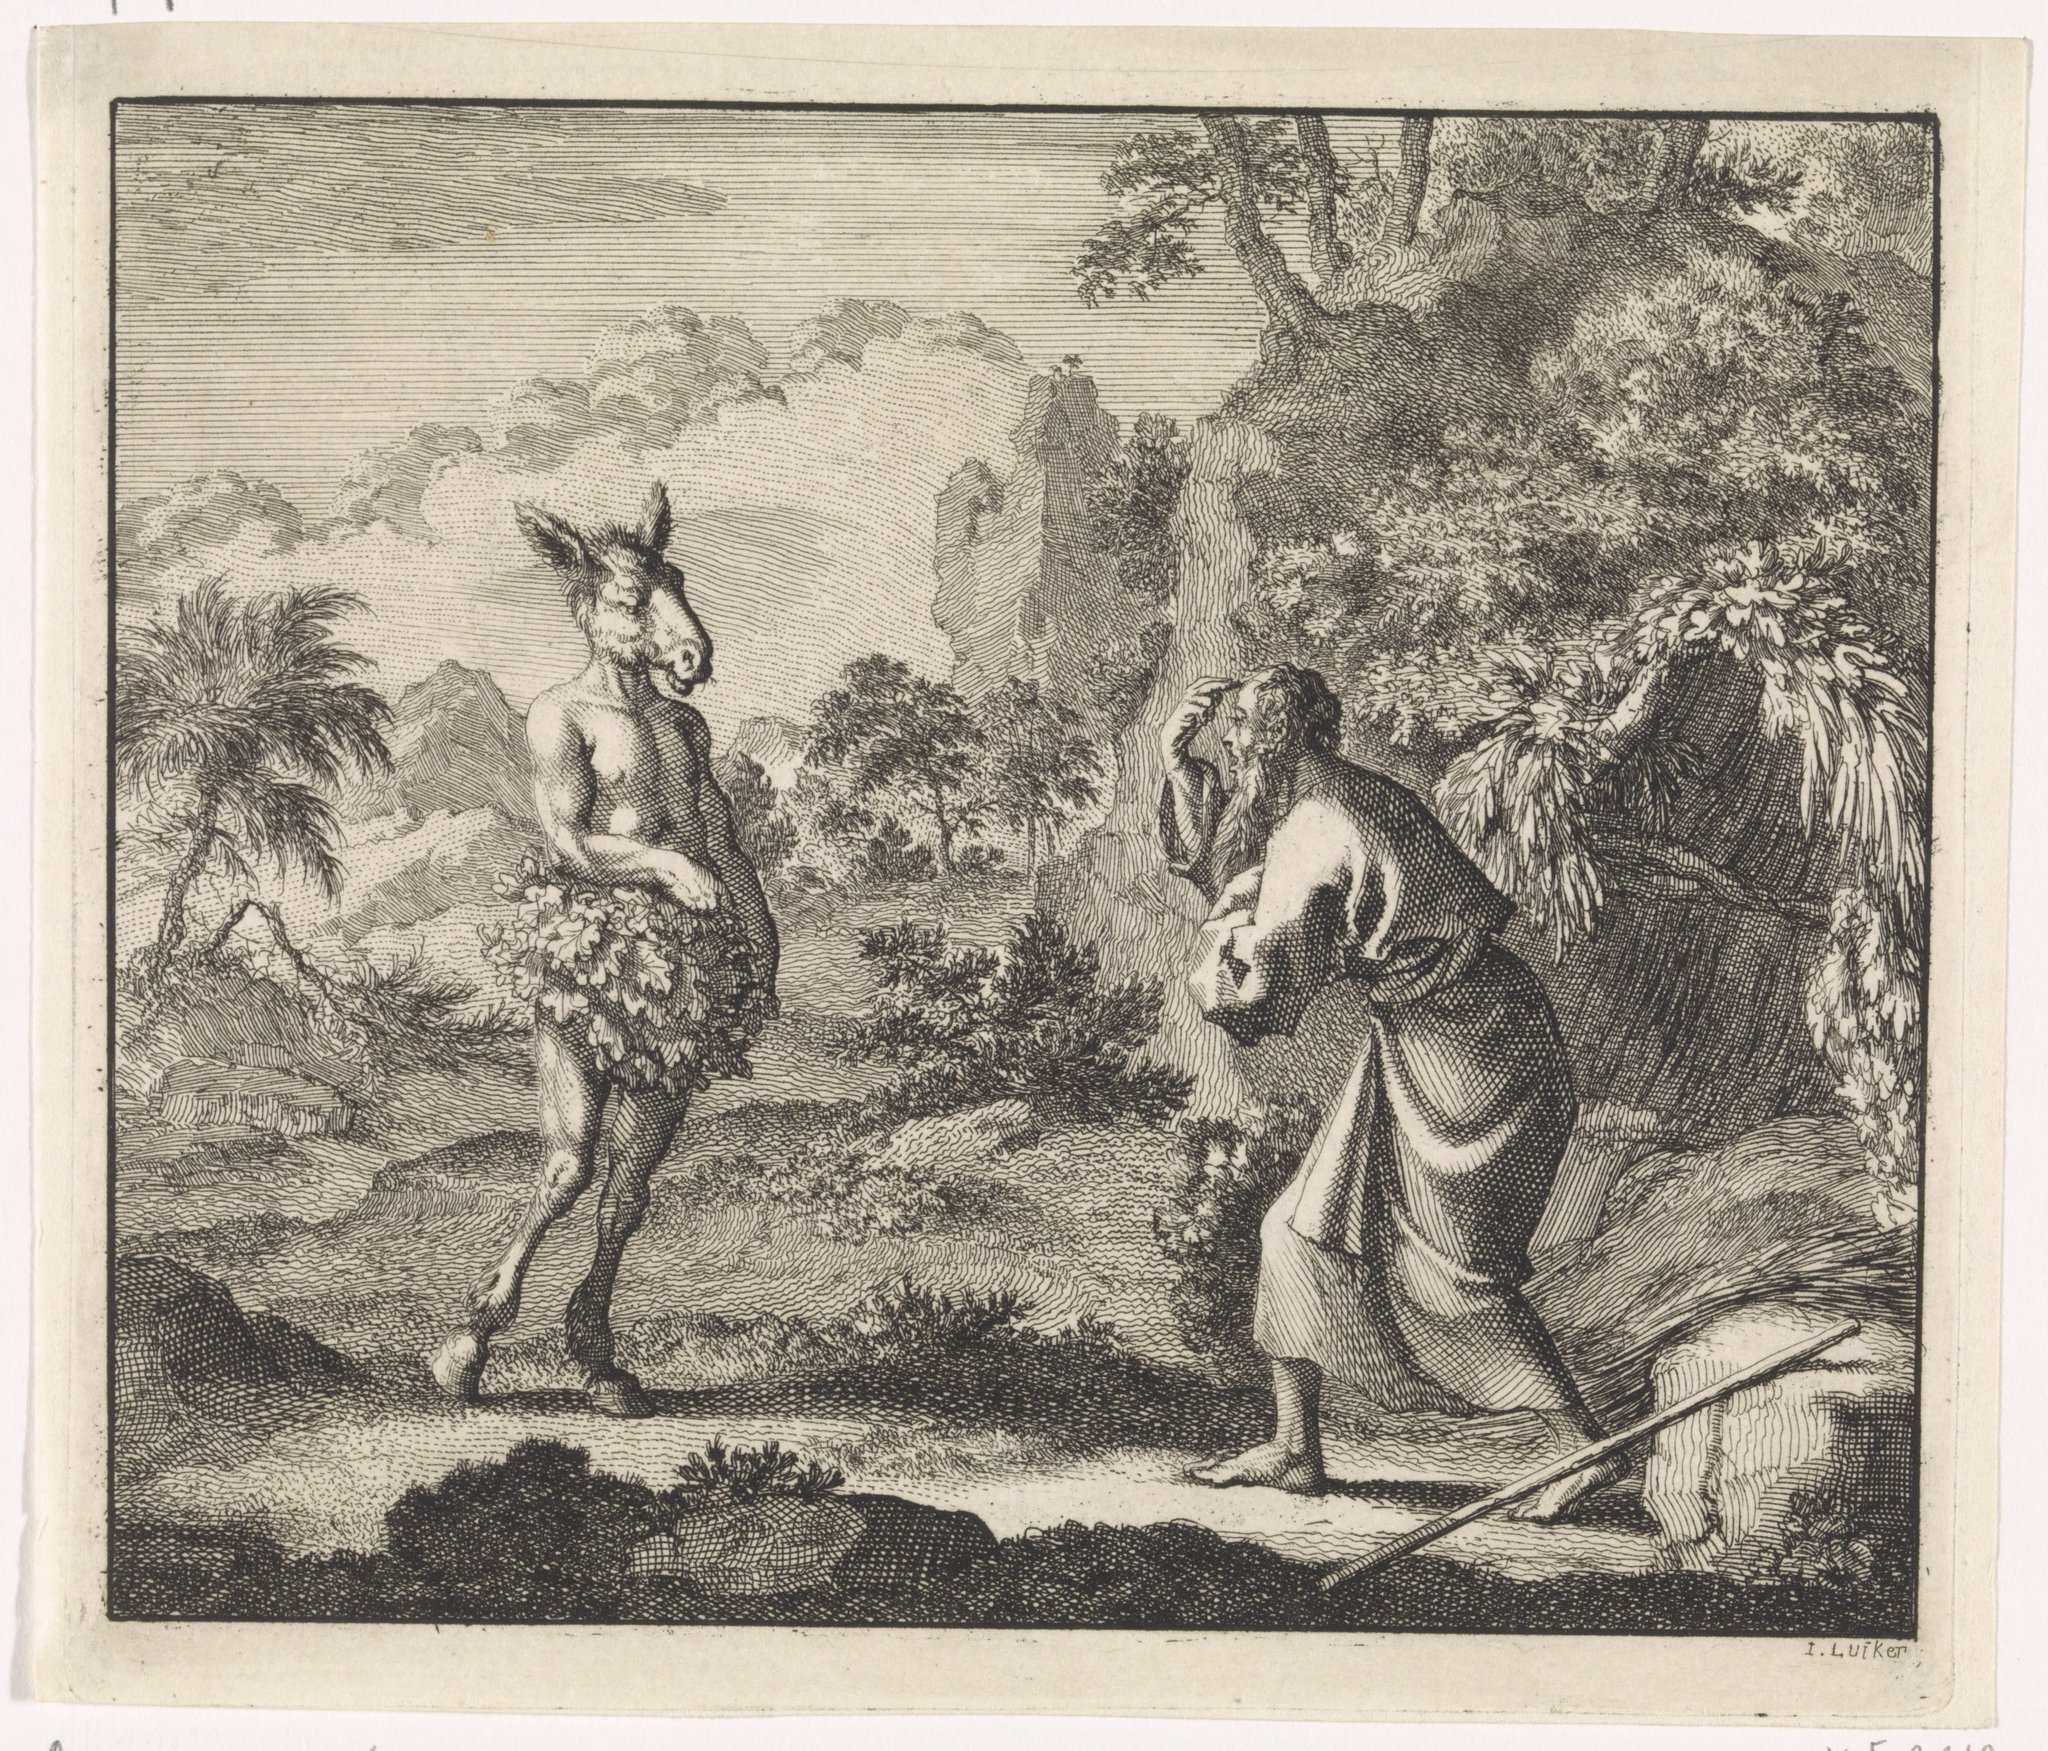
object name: print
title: Verzoeking van de heilige Antonius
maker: jan luyken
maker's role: draughtsman, print maker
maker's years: 1649-1712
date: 1701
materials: paper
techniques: etching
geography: amsterdam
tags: the early christian churches, e.g. armenians, copts, syrians, monsters with animal head, ass, donkey, st. antony abbot tormented by devils, attacking him on the ground or carrying him aloft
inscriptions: collector's mark: Lugt 2228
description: Proefdruk van een boekillustratie Arnold, Godfried. Waare afbeelding der eerste christenen. Amsterdam: Jacobus van Hardenberg, Barent Visscher en Jacobus van Nieuweveen, 1700, dl. 2.